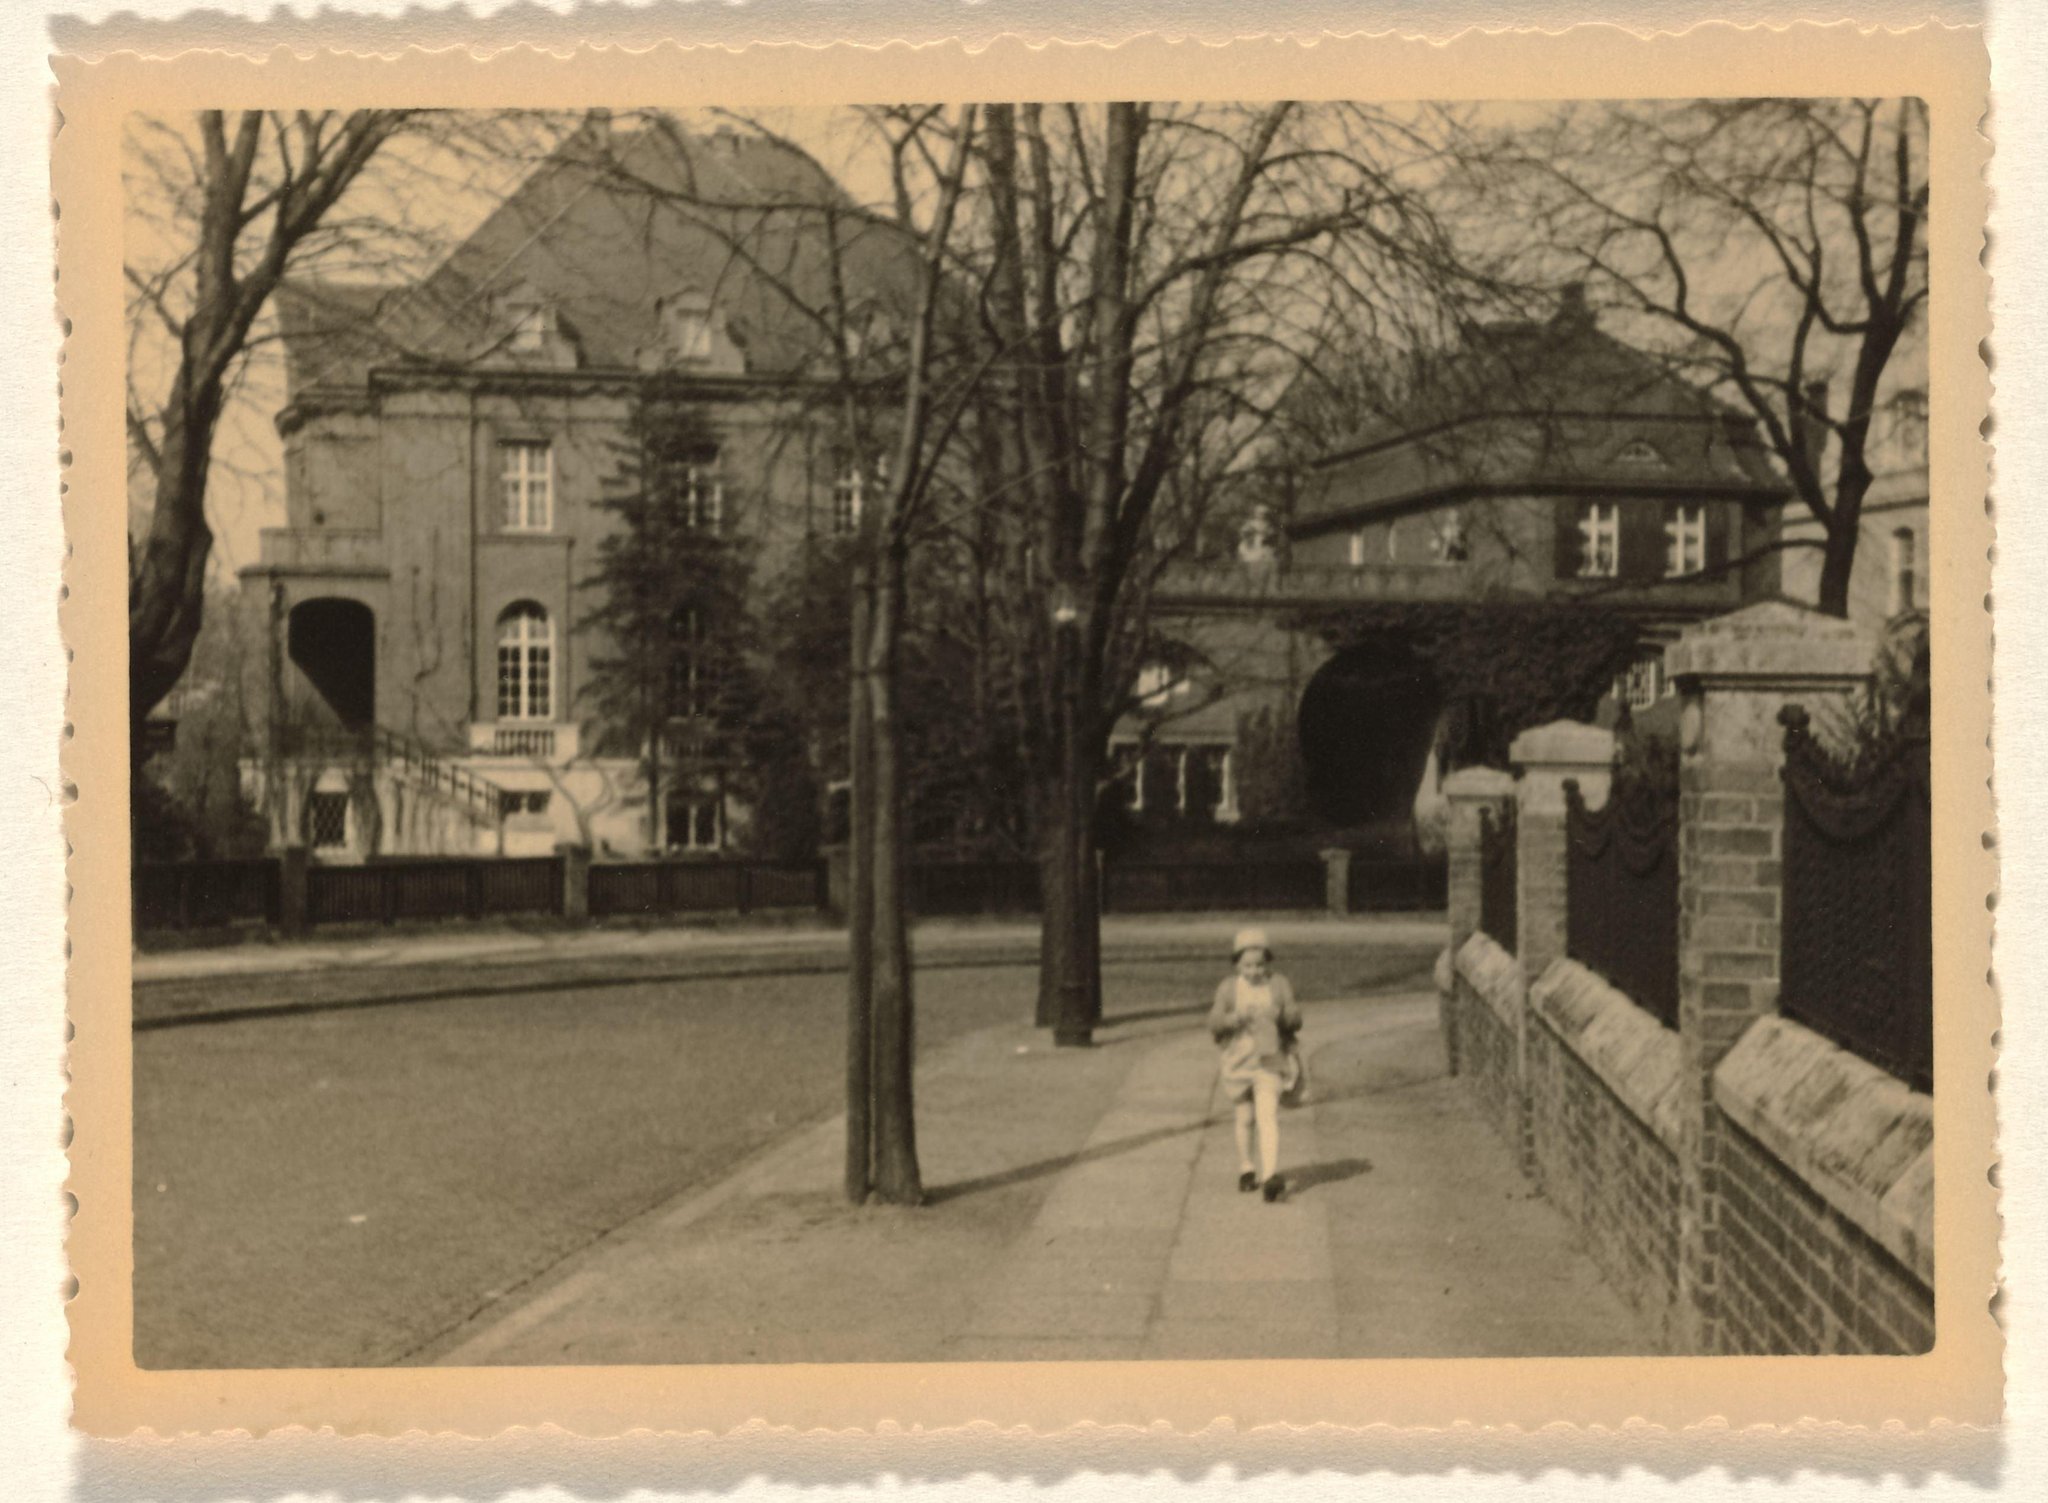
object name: photograph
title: Isabel Wachenheimer, Hamburg, 1935, Bellevue 62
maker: Anonymous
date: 1935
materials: photographic support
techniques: gelatin silver print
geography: hamburg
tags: leiden, isabel wachenheimer-elon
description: Dit object is onderdeel van de nalatenschap van Isabel Elon-Wachenheimer (1928-2010). Tot haar overlijden behoorde het samen met de andere objecten uit de nalatenschap tot haar privédomein van Isabel Wachenheimer. In die particuliere context zijn deze objecten tezamen en individueel aandenkens - aan de jeugd, ouders en familie van Isabel Wachenheimer vóór en tijdens de Shoah en aan haar leven na de Tweede Wereldoorlog. Isabel Wachenheimer, die van juni 1943 tot mei 1945 gevangen zat in Kamp Westerbork, Theresienstadt, Auschwitz, Lenzing a/d Oberdonau (een buitenkamp van Mauthausen), overleefde de Shoah. Haar ouders – Eugène Wachenheimer en Else Wachenheimer-Moos - werden op 14 oktober 1944 in Auschwitz-Birkenau vermoord.